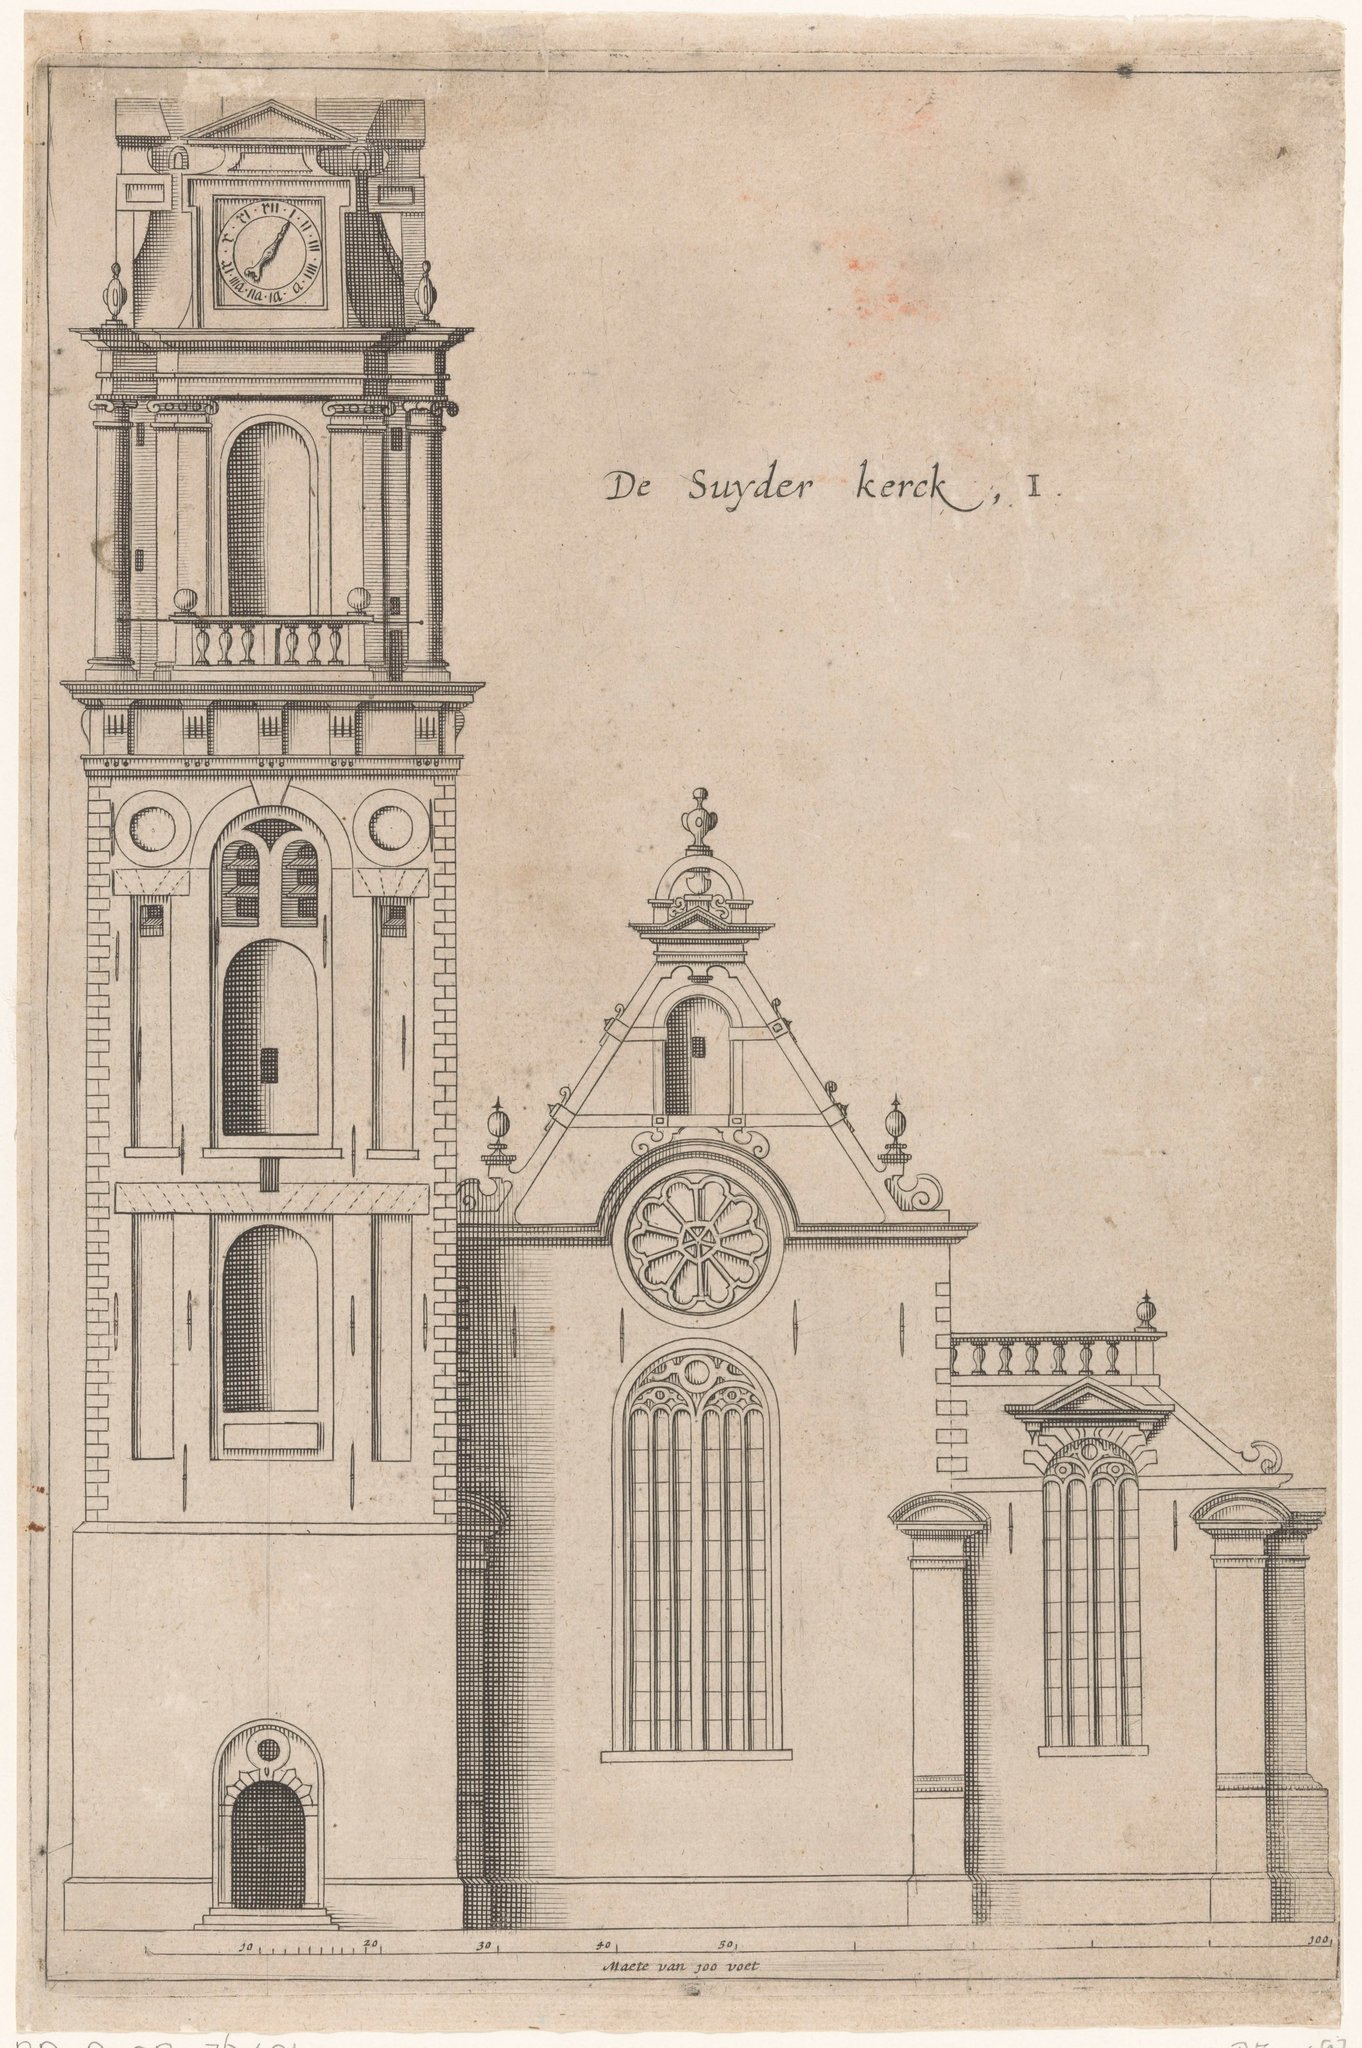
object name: ornament print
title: Opstand van de frontfaçade van de Zuiderkerk met toren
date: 1631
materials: paper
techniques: engraving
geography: amsterdam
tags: parts of church exterior and annexes: façade, exterior ~ architectural design or model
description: Prent uit: Keyser, Hendrick de. Architectura moderna ofte bouwinge van onsen tyt (...) alle gedaen by (...) Amsterdam: Danckerts, Cornelis, 1631.